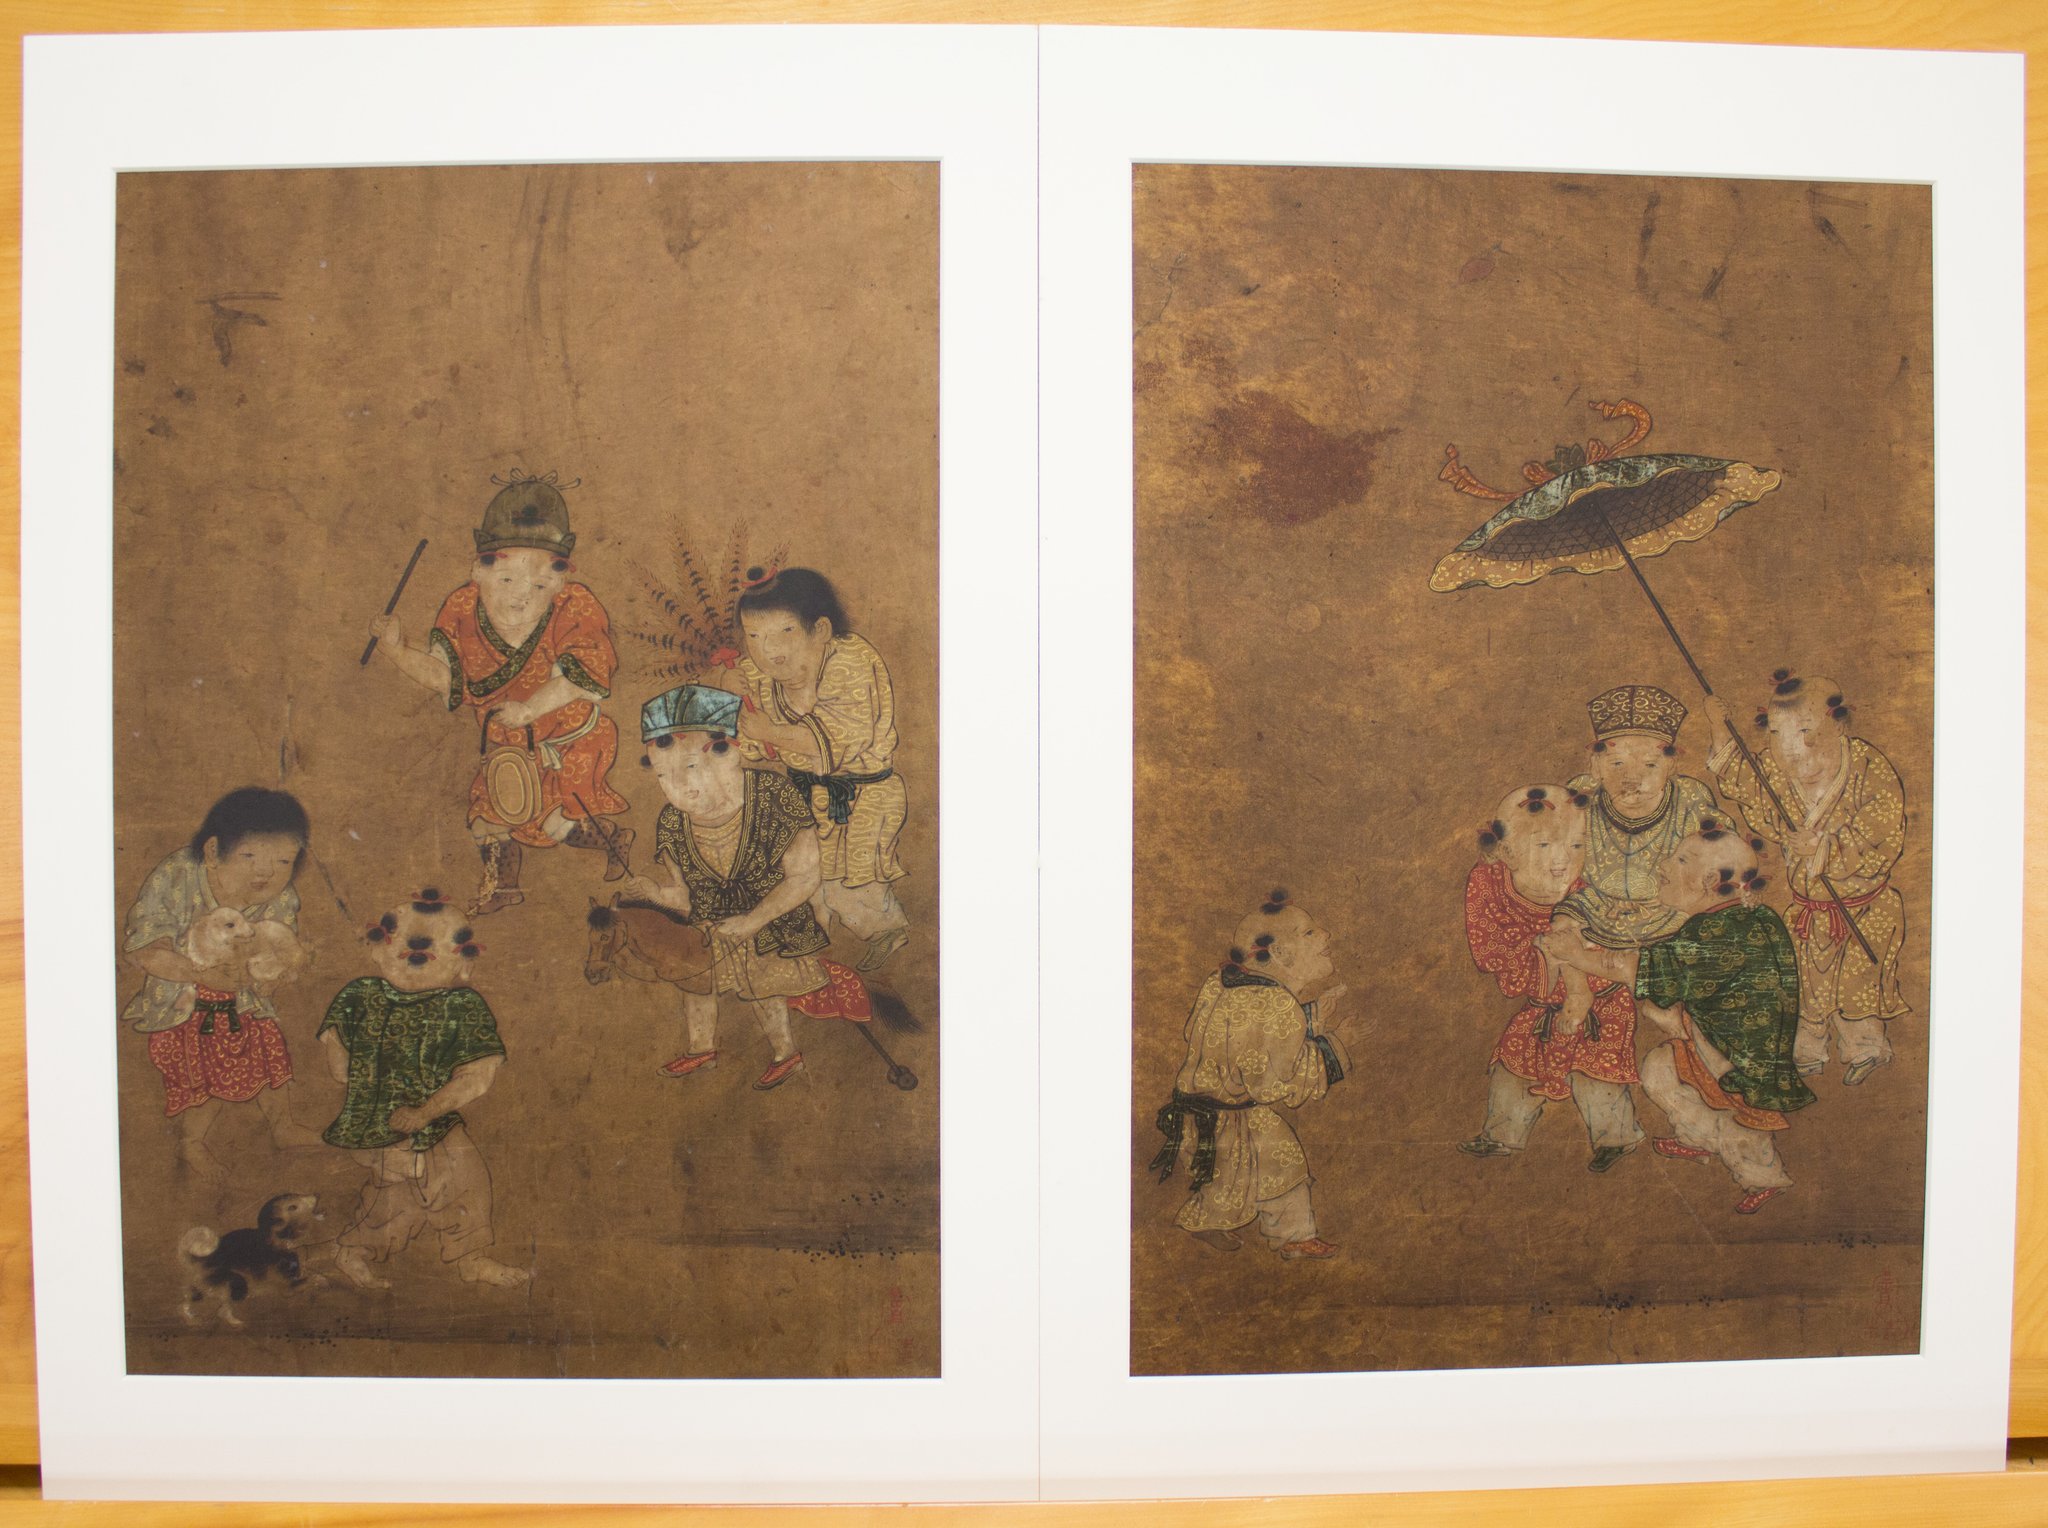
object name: painting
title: Chinese Children at Play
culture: japanese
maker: isei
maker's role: artist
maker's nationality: japanese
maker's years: 1536-1570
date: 1534-1566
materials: ink, paper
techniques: painting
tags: animals,boys,men,playing